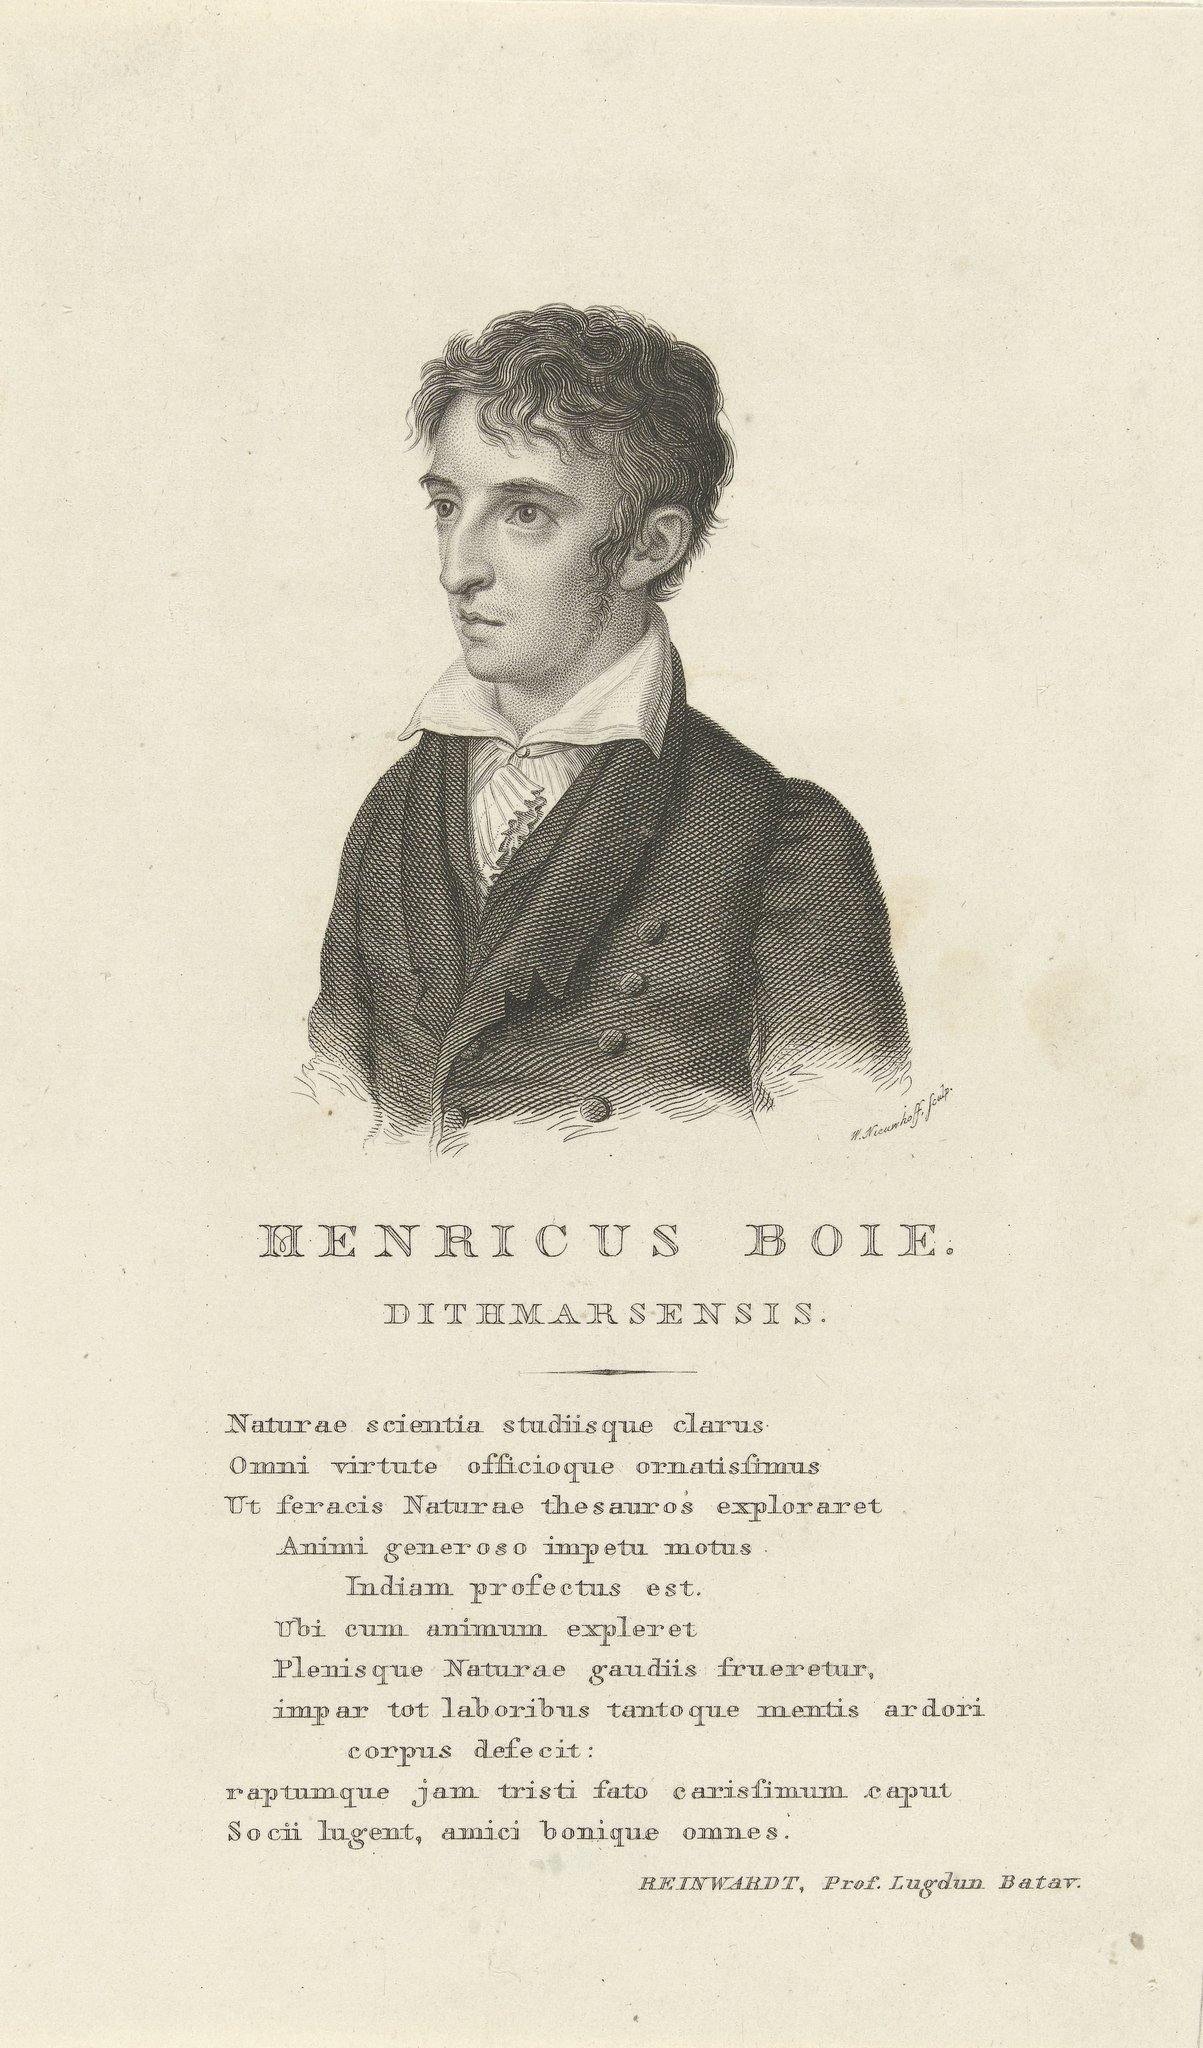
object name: print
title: Henricus Boie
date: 1827-1837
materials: paper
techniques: engraving, etching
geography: amsterdam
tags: meldorf, buitenzorg, bioloog, heinrich boie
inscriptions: collector's mark: Lugt 2228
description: Buste van zoöloog Henricus Boie naar links. Onderaan een elfregelig vers in het Latijn.